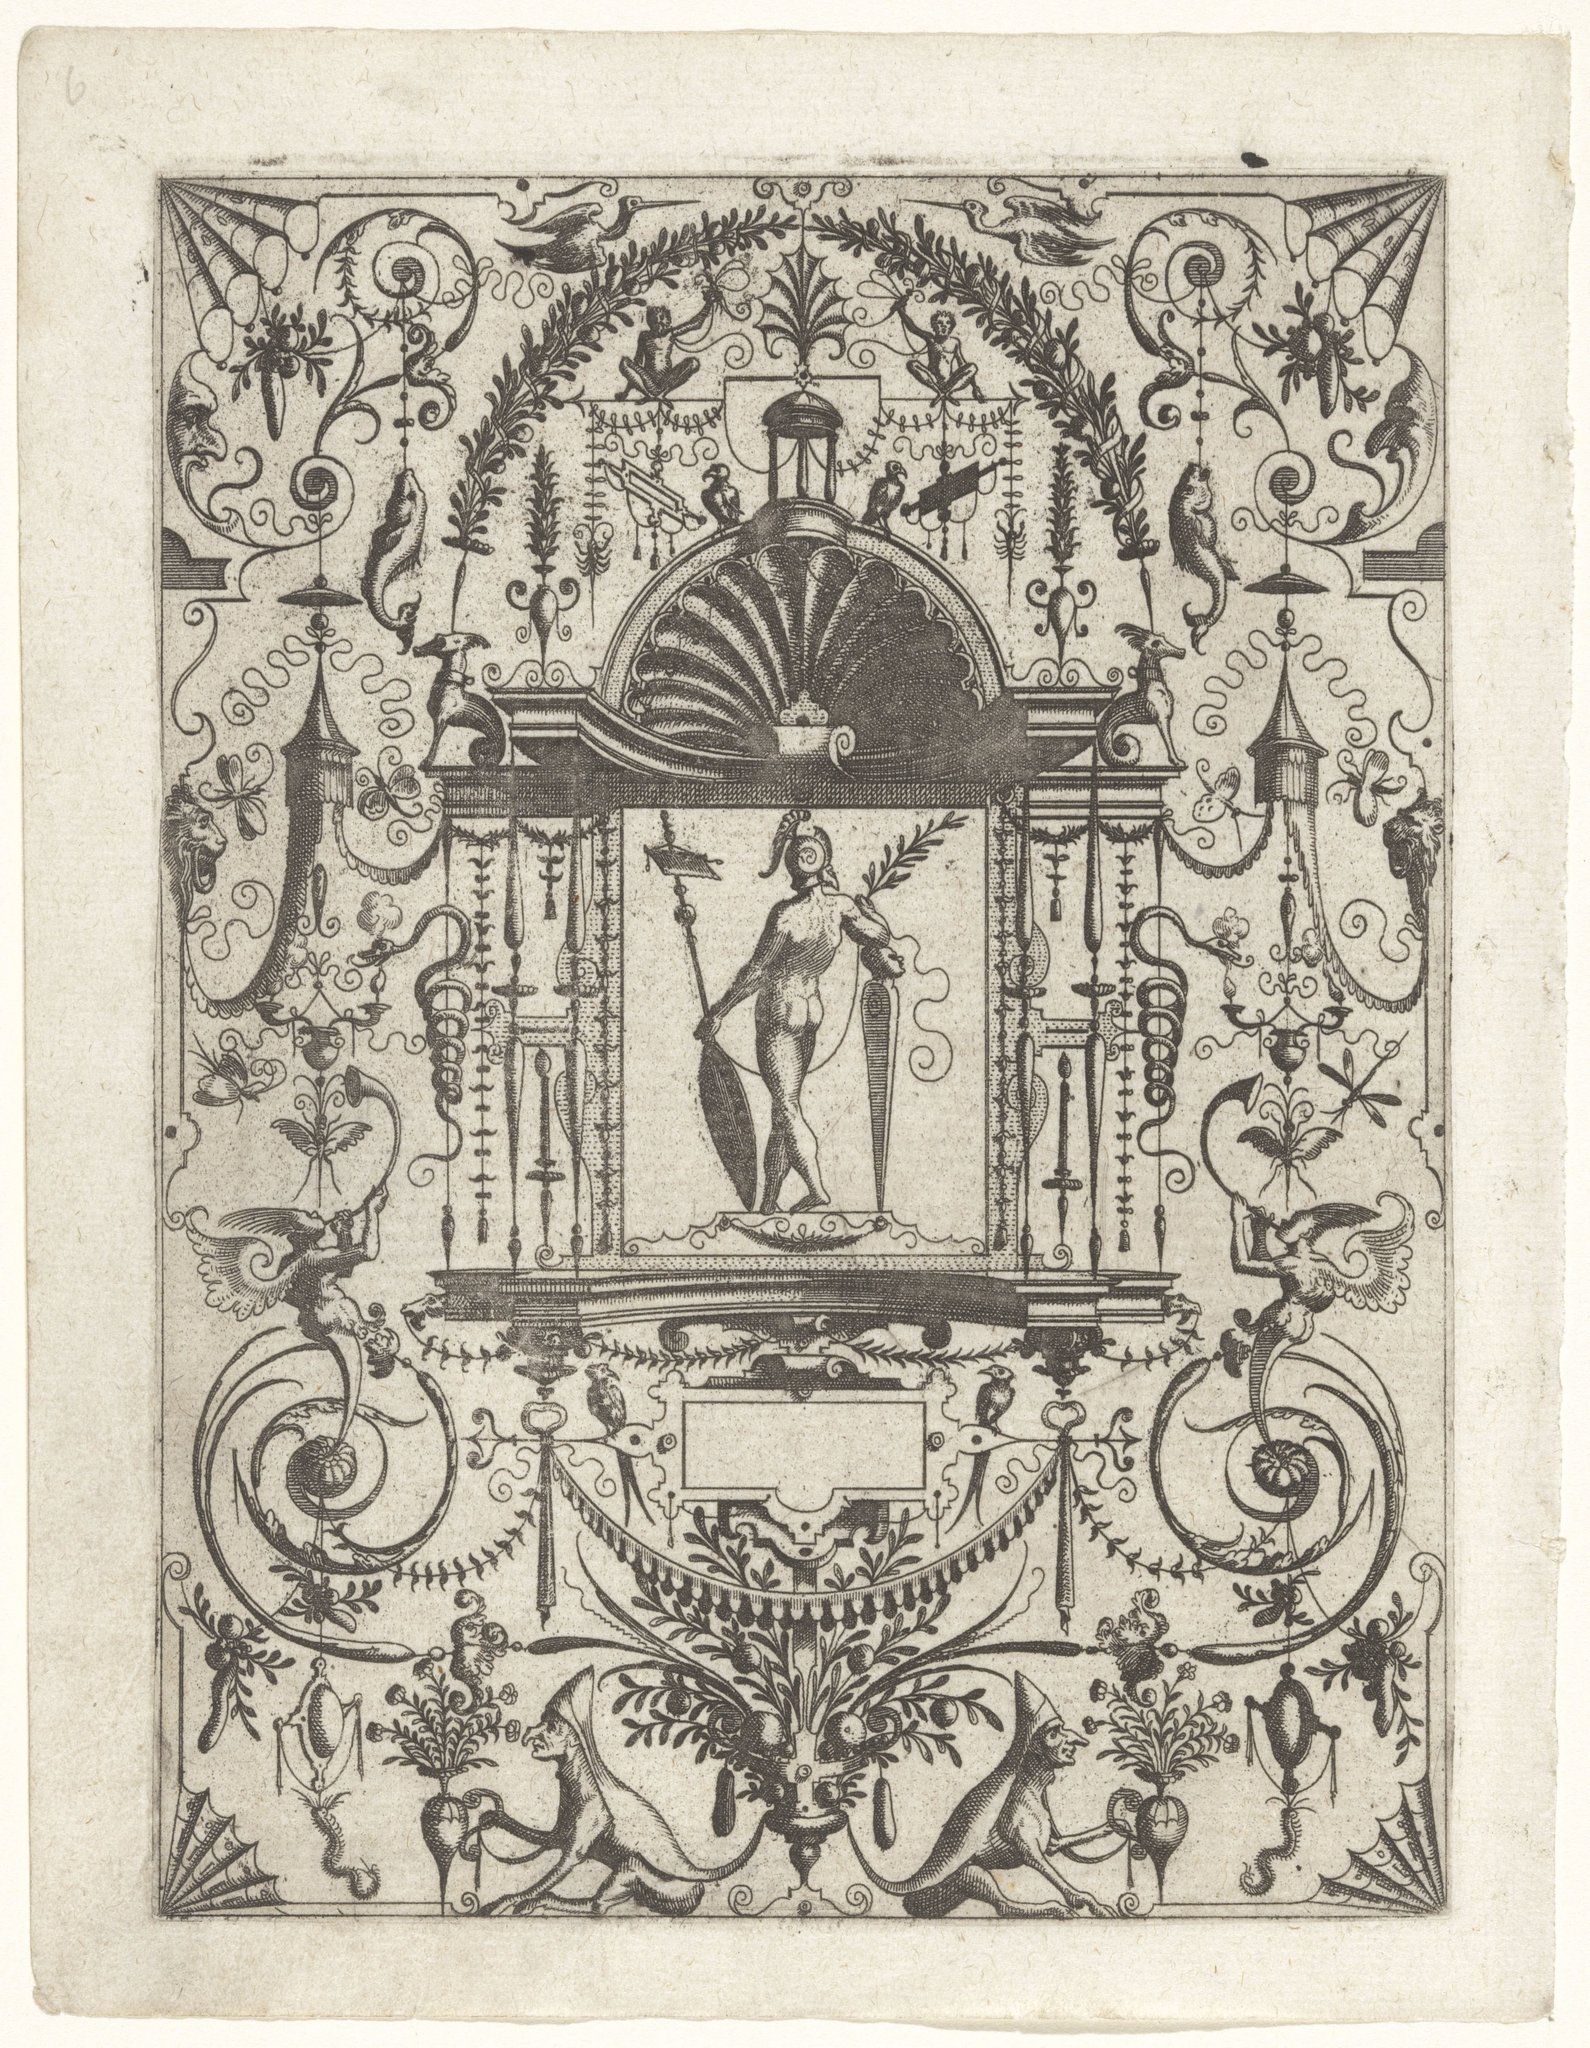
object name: print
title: Titelblad en 6 bladen met grotesken uit: "Grotesco in diverse manieren (...)"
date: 1565-1571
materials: paper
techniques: etching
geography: netherlands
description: Krijger met schild, veldteken en palmtak, leunend op een herme. Uit serie van titelblad + 16 bladen met cartouches of architectuurfantasieën met een voorstelling in een omlijsting van grotesken met fabelwezens, dieren, guirlandes, trofeeën en mascarons.